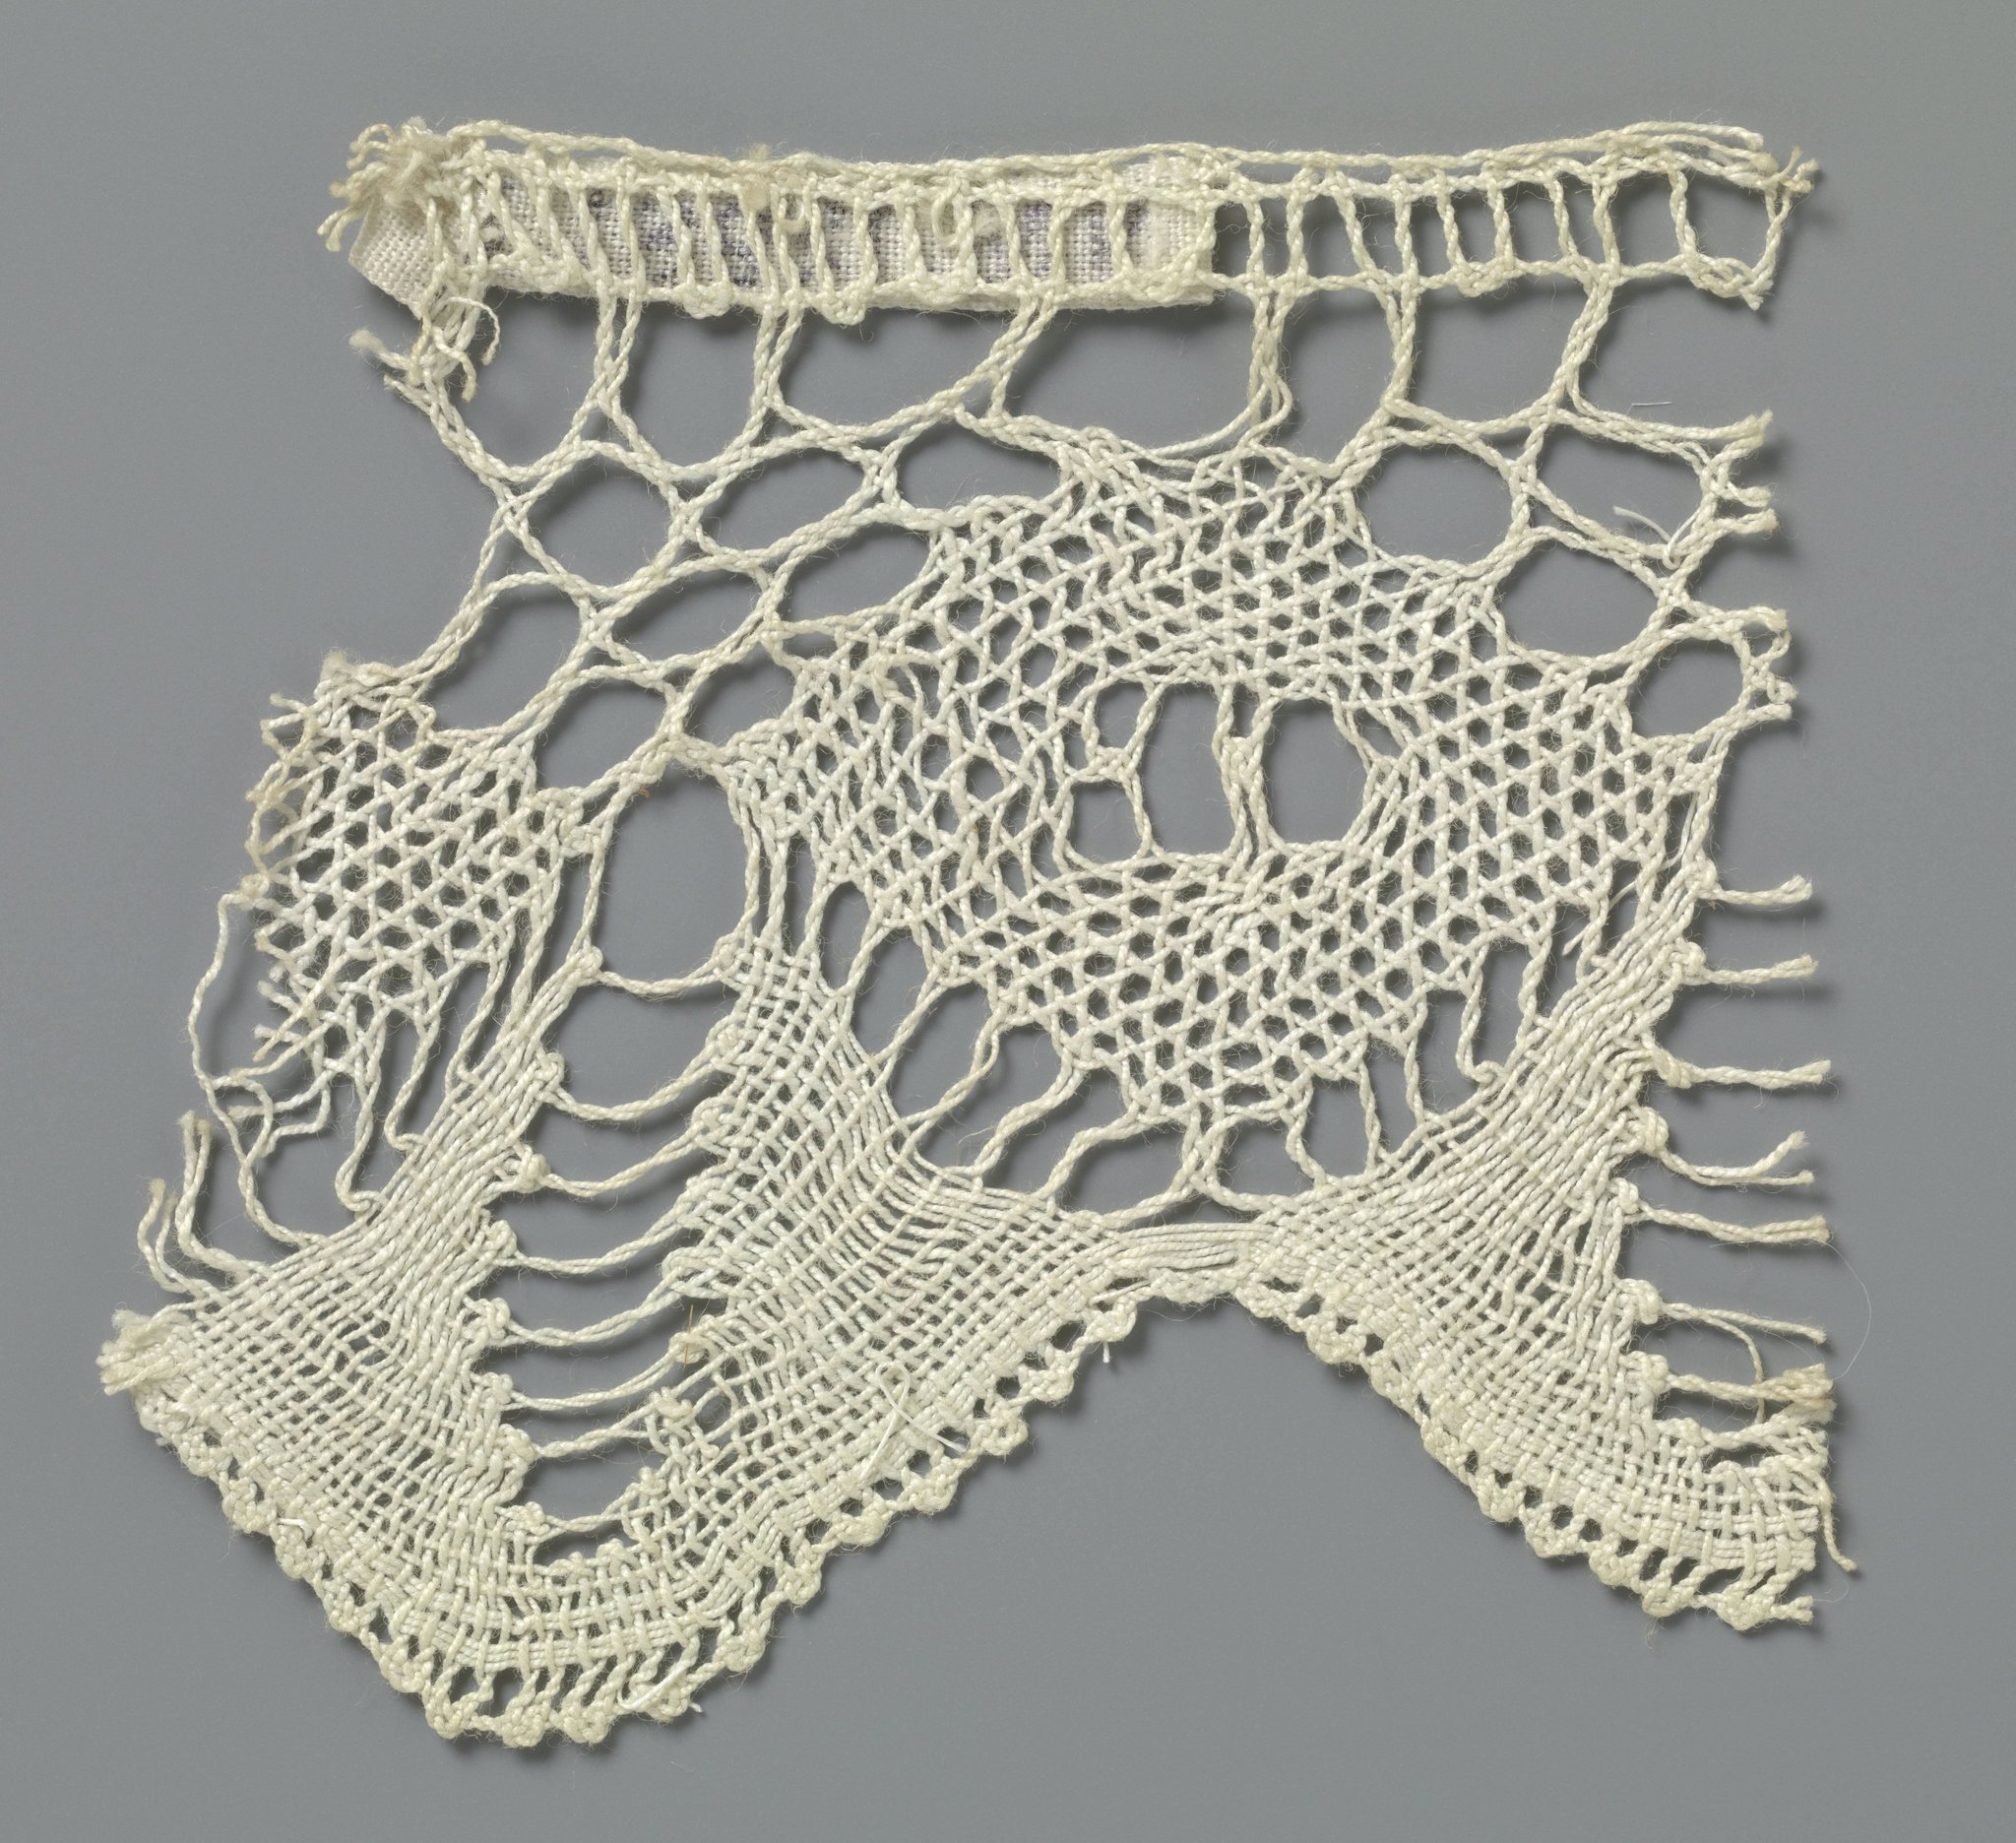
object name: strip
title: Strook kloskant met ruit en waaiervormige schulpen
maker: Anonymous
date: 1800-1899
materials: linen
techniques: lace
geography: brazil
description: Strook naturelkleurige kloskant, stropkant. Het zich herhalende patroon bestaat op de middenbaan uit een ruit. Tussen de opeenvolgende ruiten hangt steeds een waaiervormige schulp naar beneden, met een opengewerkte verticale baan. De ruiten zijn langs de bovenzijde met elkaar verbonden door een grove maasgrond, een Parijse grond. De ruiten zijn gemaakt in netslag en de waaiers in linnenslag. De bovenzijde van de strook is recht afgewerkt. De schulpen zijn afgewerkt met picots.